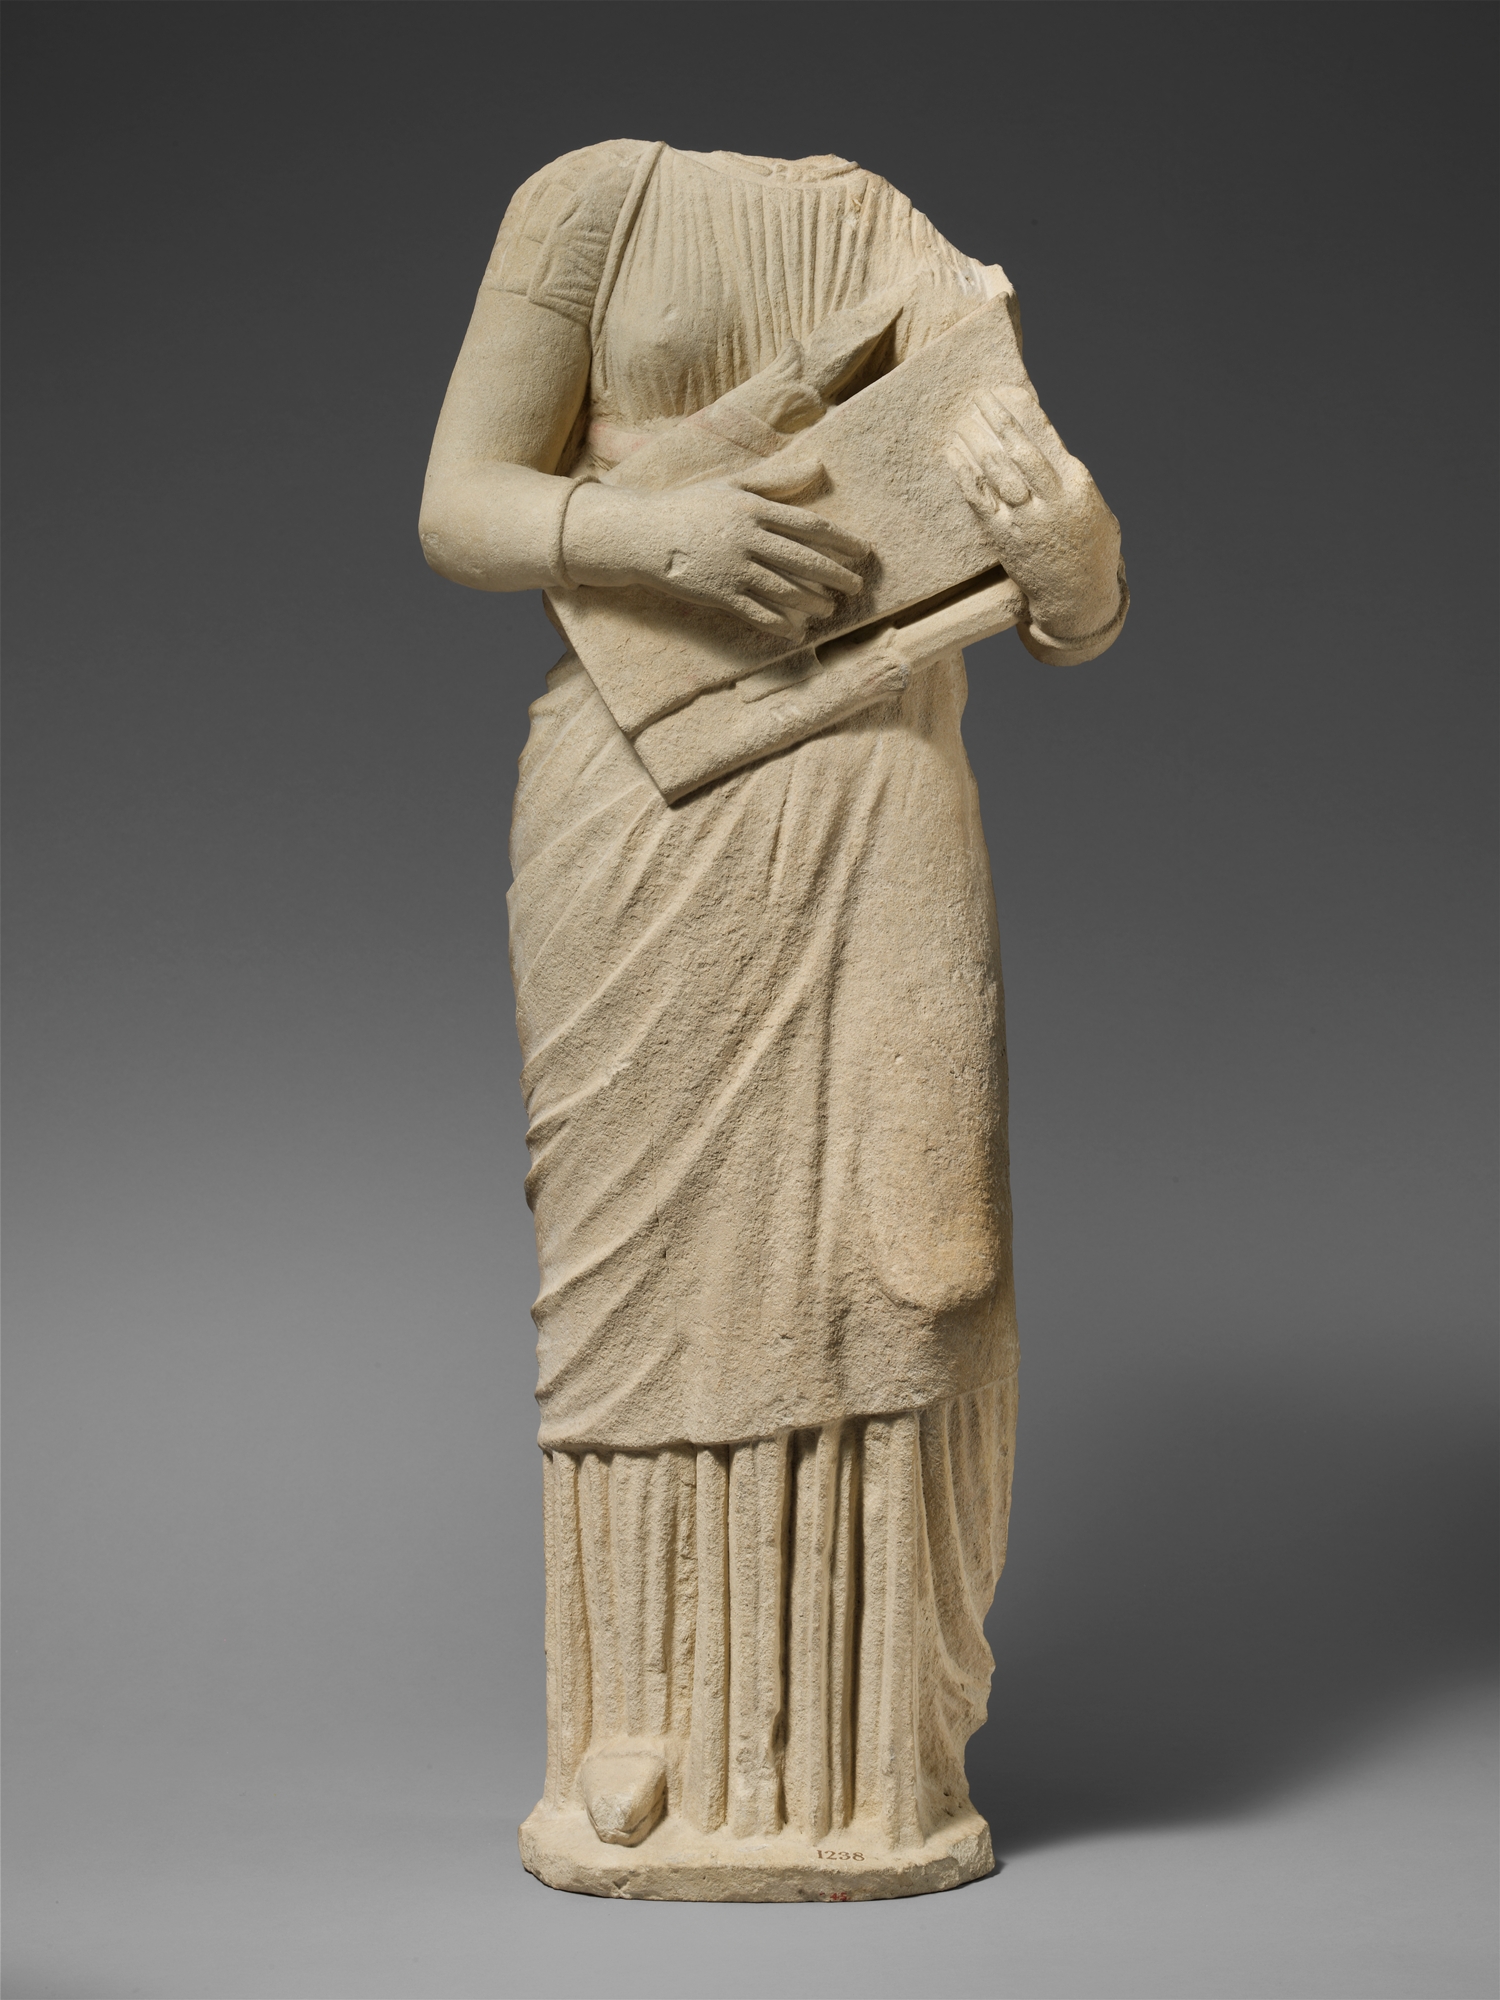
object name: statue of a female lyre player in greek dress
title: Limestone statue of a female lyre player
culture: cypriot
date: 3900 BCE-100 CE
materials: limestone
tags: musical instruments,women